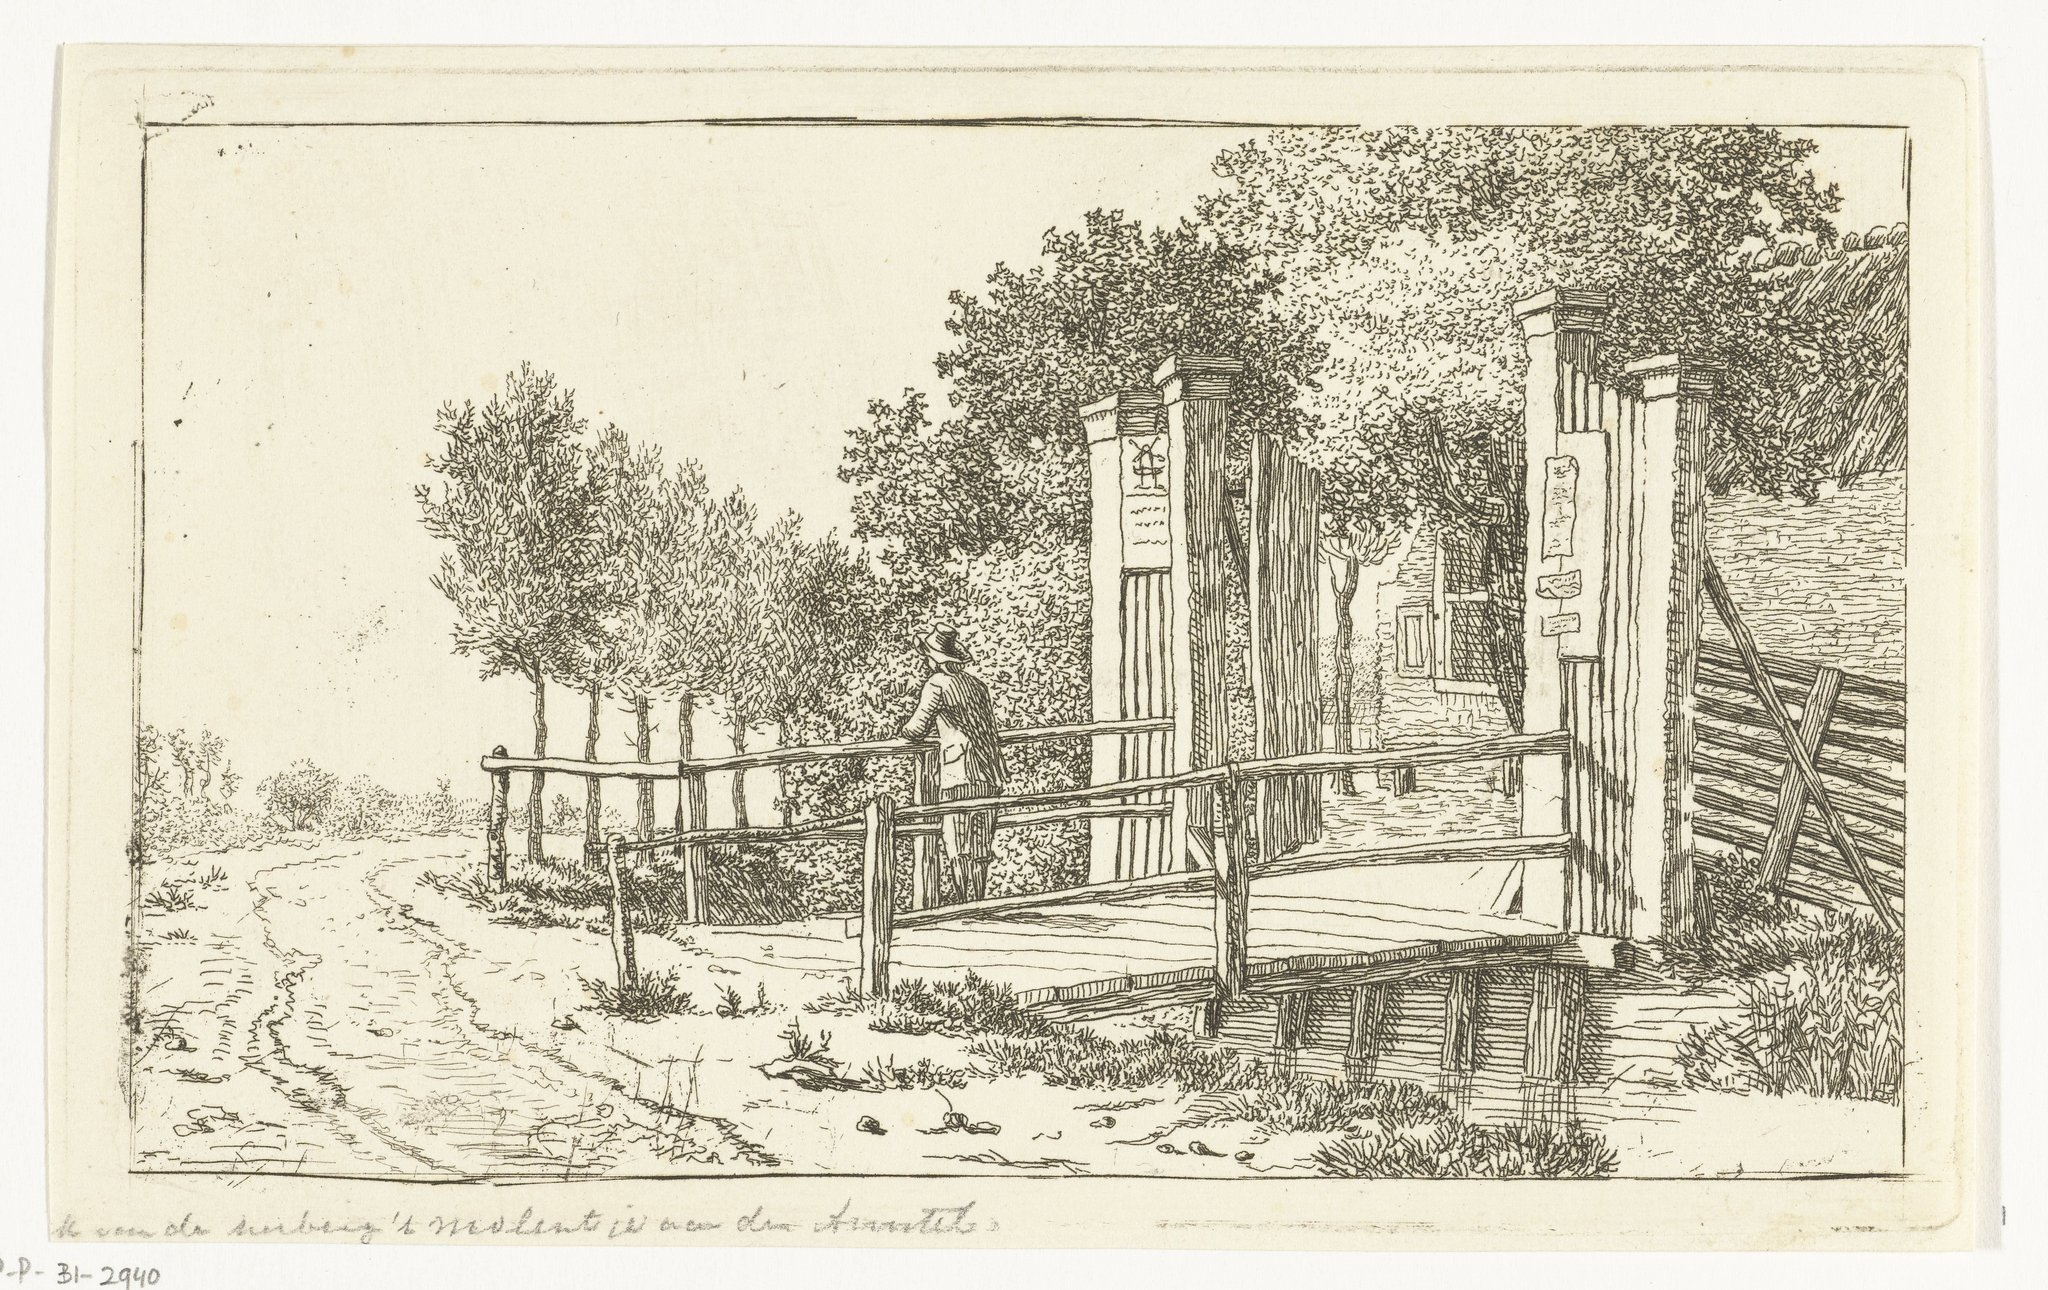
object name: print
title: Hek van de herberg het Molentje aan de Amstel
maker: anthonie van den bos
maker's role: draughtsman, print maker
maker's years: 1763-1838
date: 1805-1815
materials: paper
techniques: etching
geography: netherlands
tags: inn, coffee-house, public house, etc.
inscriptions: collector's mark: Lugt 2228